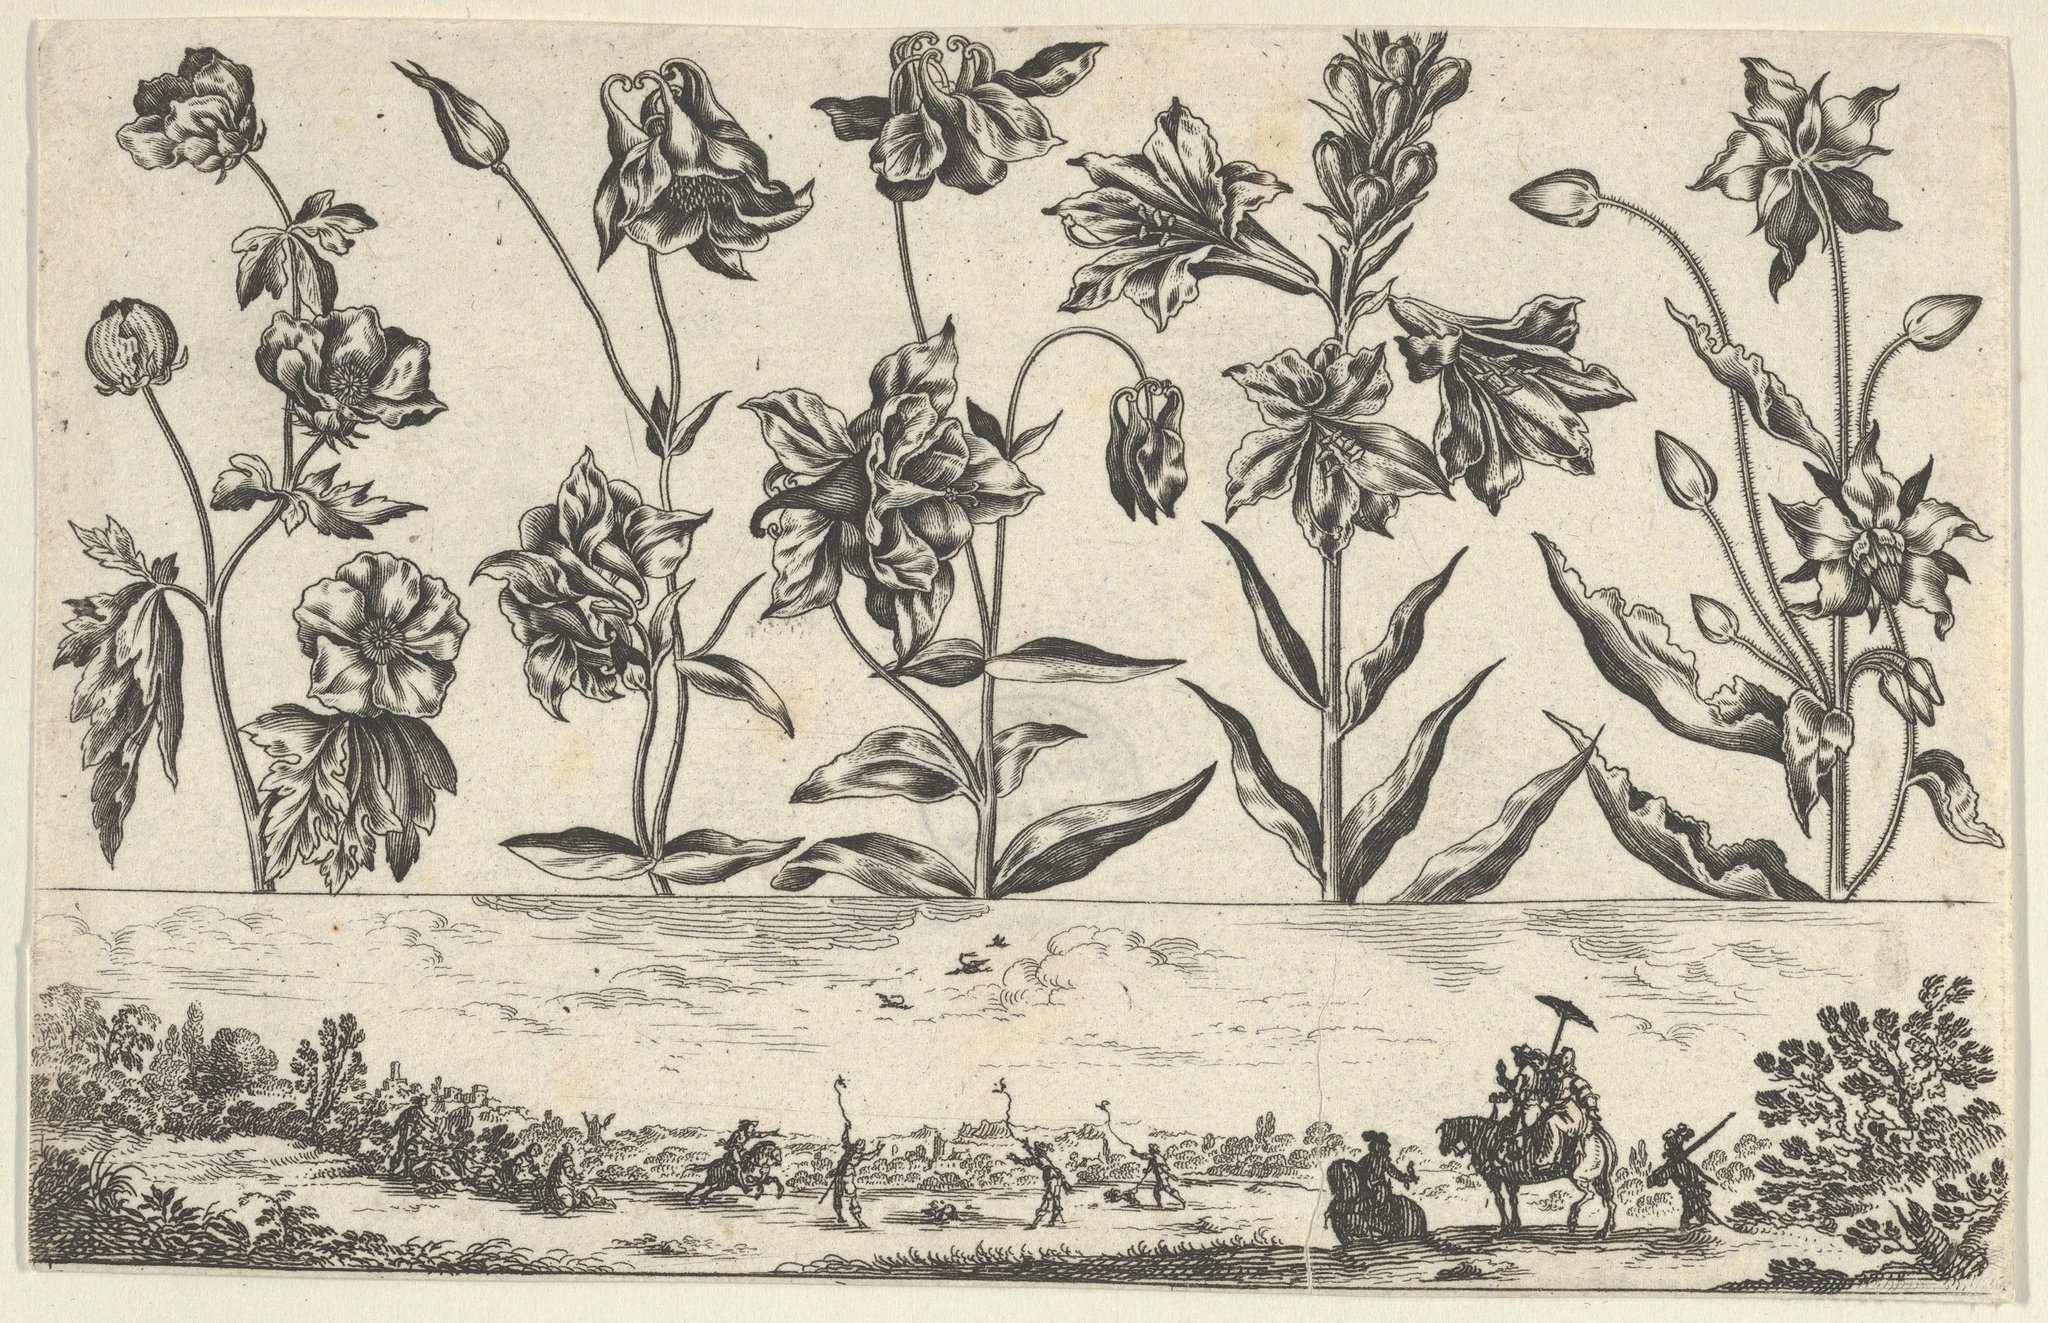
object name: print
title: Horizontal Panel with a Row of Flowers Above a Frieze with a Hunting Scene in a Landscape, from "Livre Nouveau de Fleurs Tres-Util"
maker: nicolas cochin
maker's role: artist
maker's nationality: french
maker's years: 1610-1686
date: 1645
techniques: engraving, etching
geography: france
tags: horses,flowers